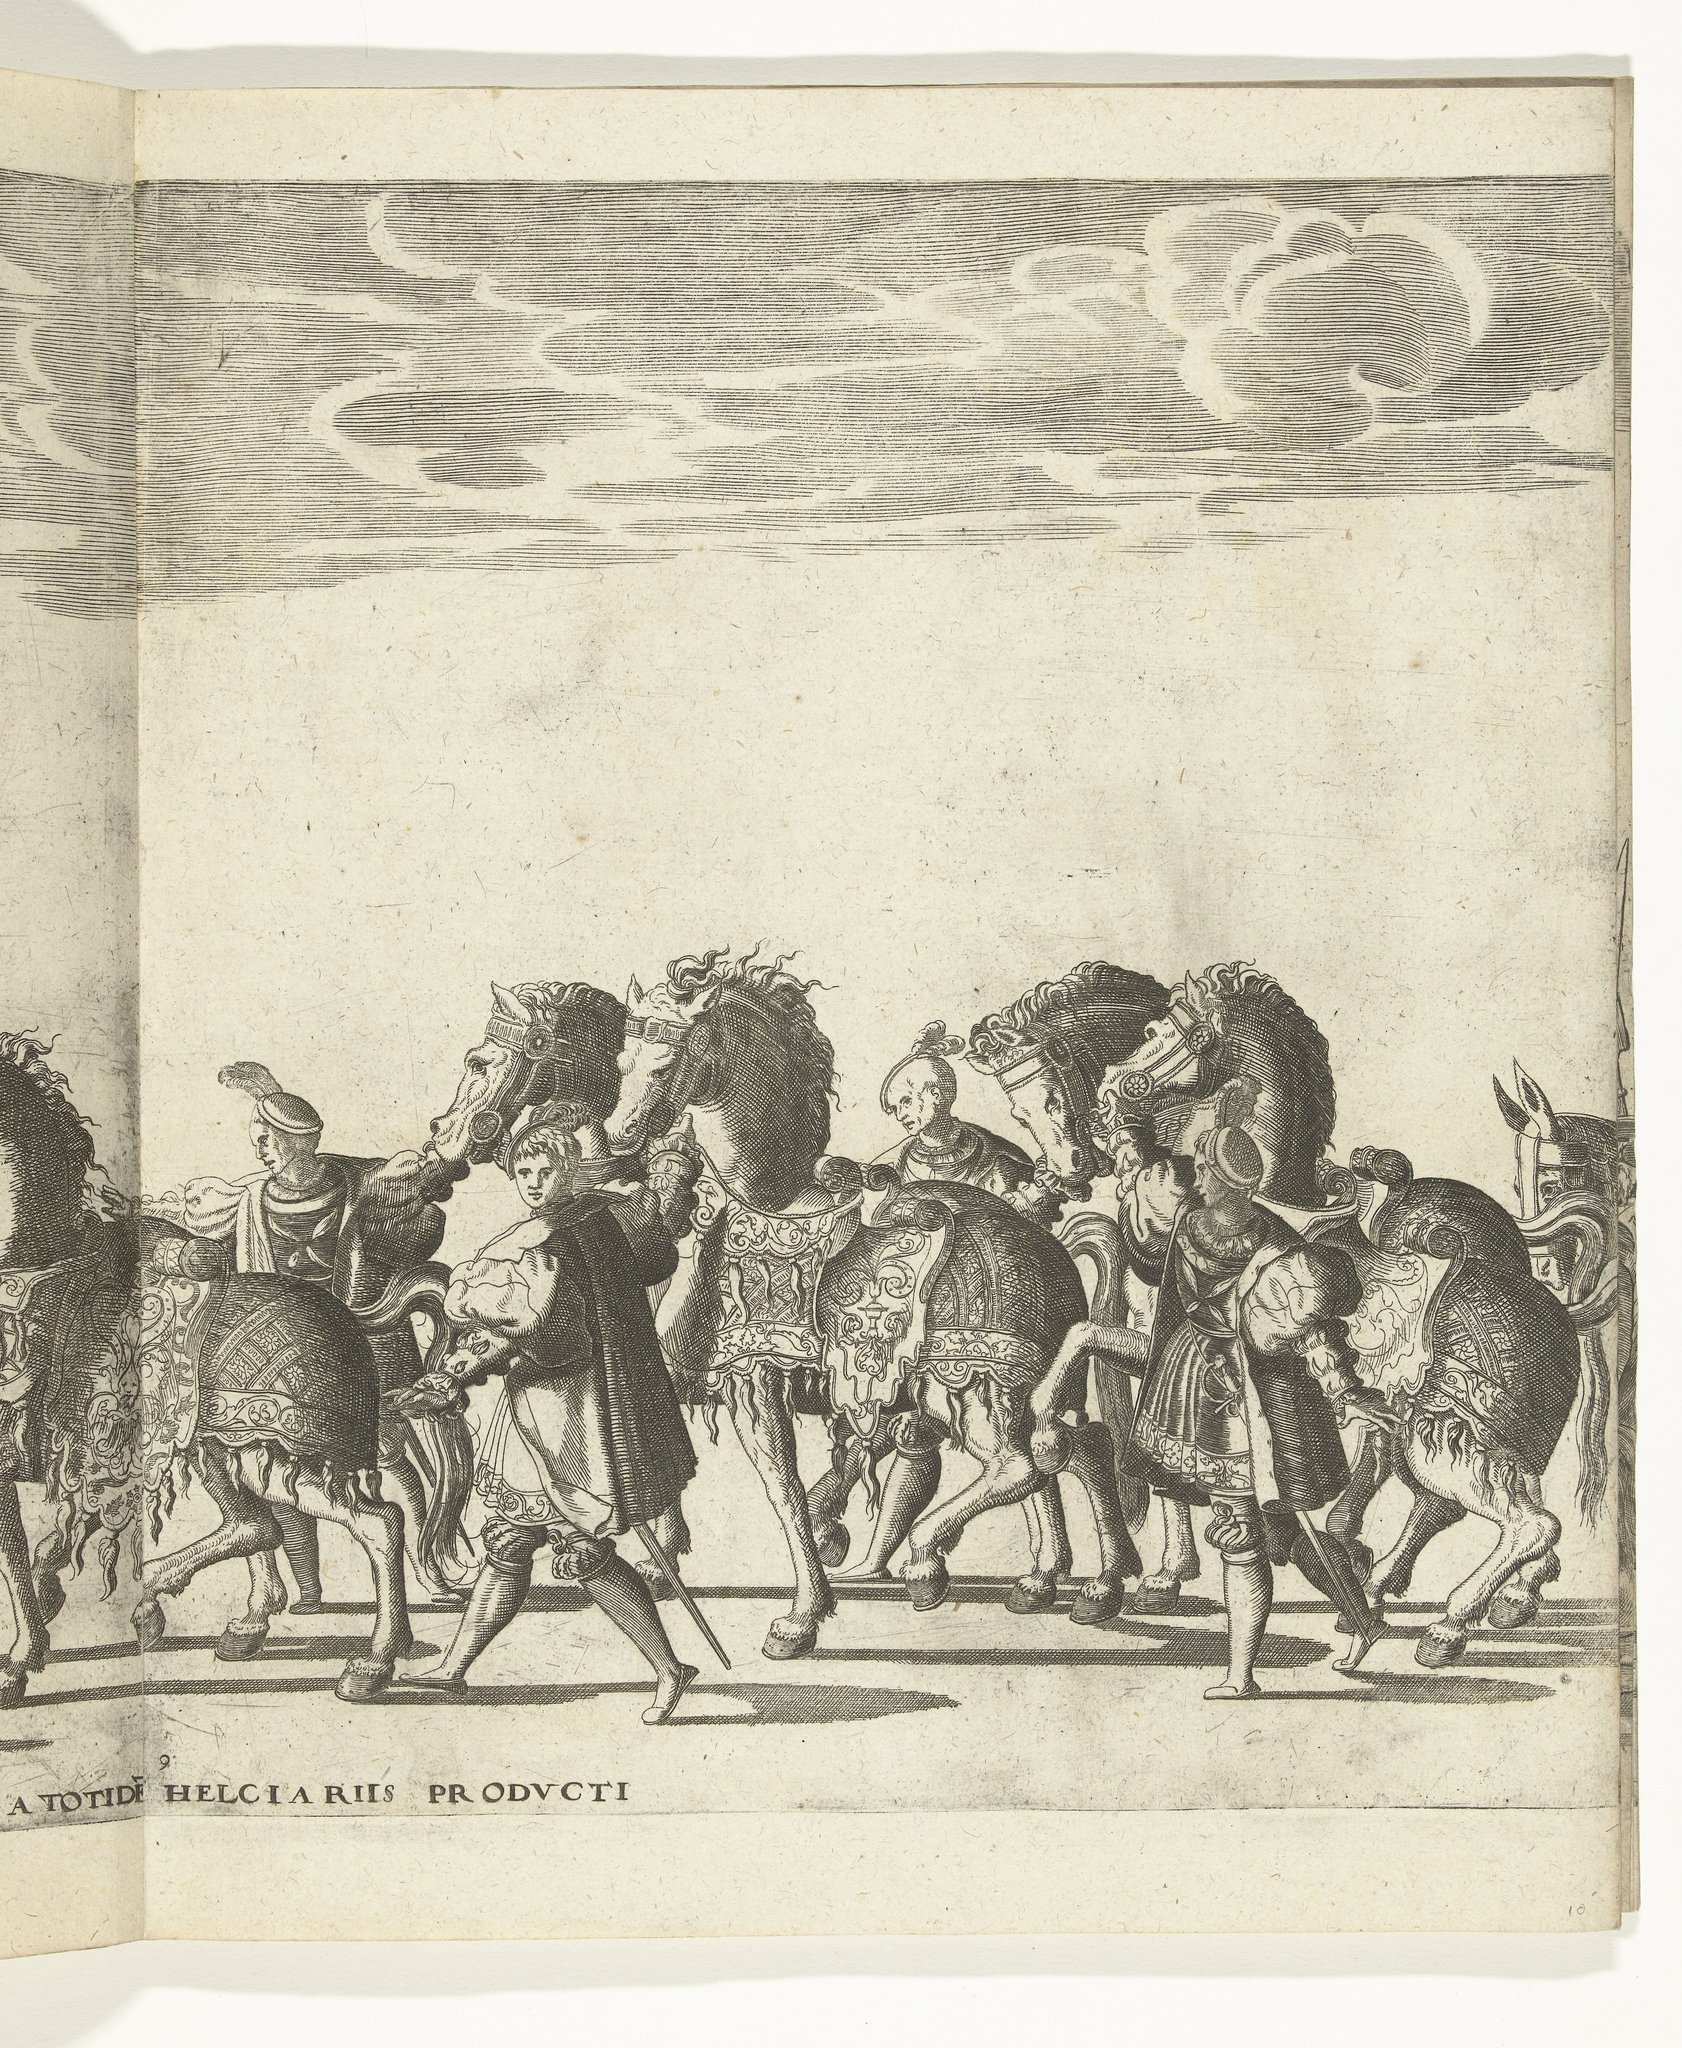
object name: propagandaprent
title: Voetknechten met paarden, plaat 9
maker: nicolaas hogenberg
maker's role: draughtsman, painter, print maker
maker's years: 1500-1539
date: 1530-1536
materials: paper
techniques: engraving, etching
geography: mechelen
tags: ghent, charles v (holy roman emperor and king of spain), festivities (+ parade, pageant, cavalcade ~ festive activities)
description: In plaats van de geneologische afstamming van Karel V in het huis van Oostenrijk is in deze uitgave bovenin de platen een nieuw lucht gegraveerd. De platen zijn genummerd 1-38. Deze uitgave is later dan die van Hondius. De platen zijn aanelkaar geplakt en vormen zo één lang (opgevouwen) fries. Het opgevouwen fries ligt los in een map.